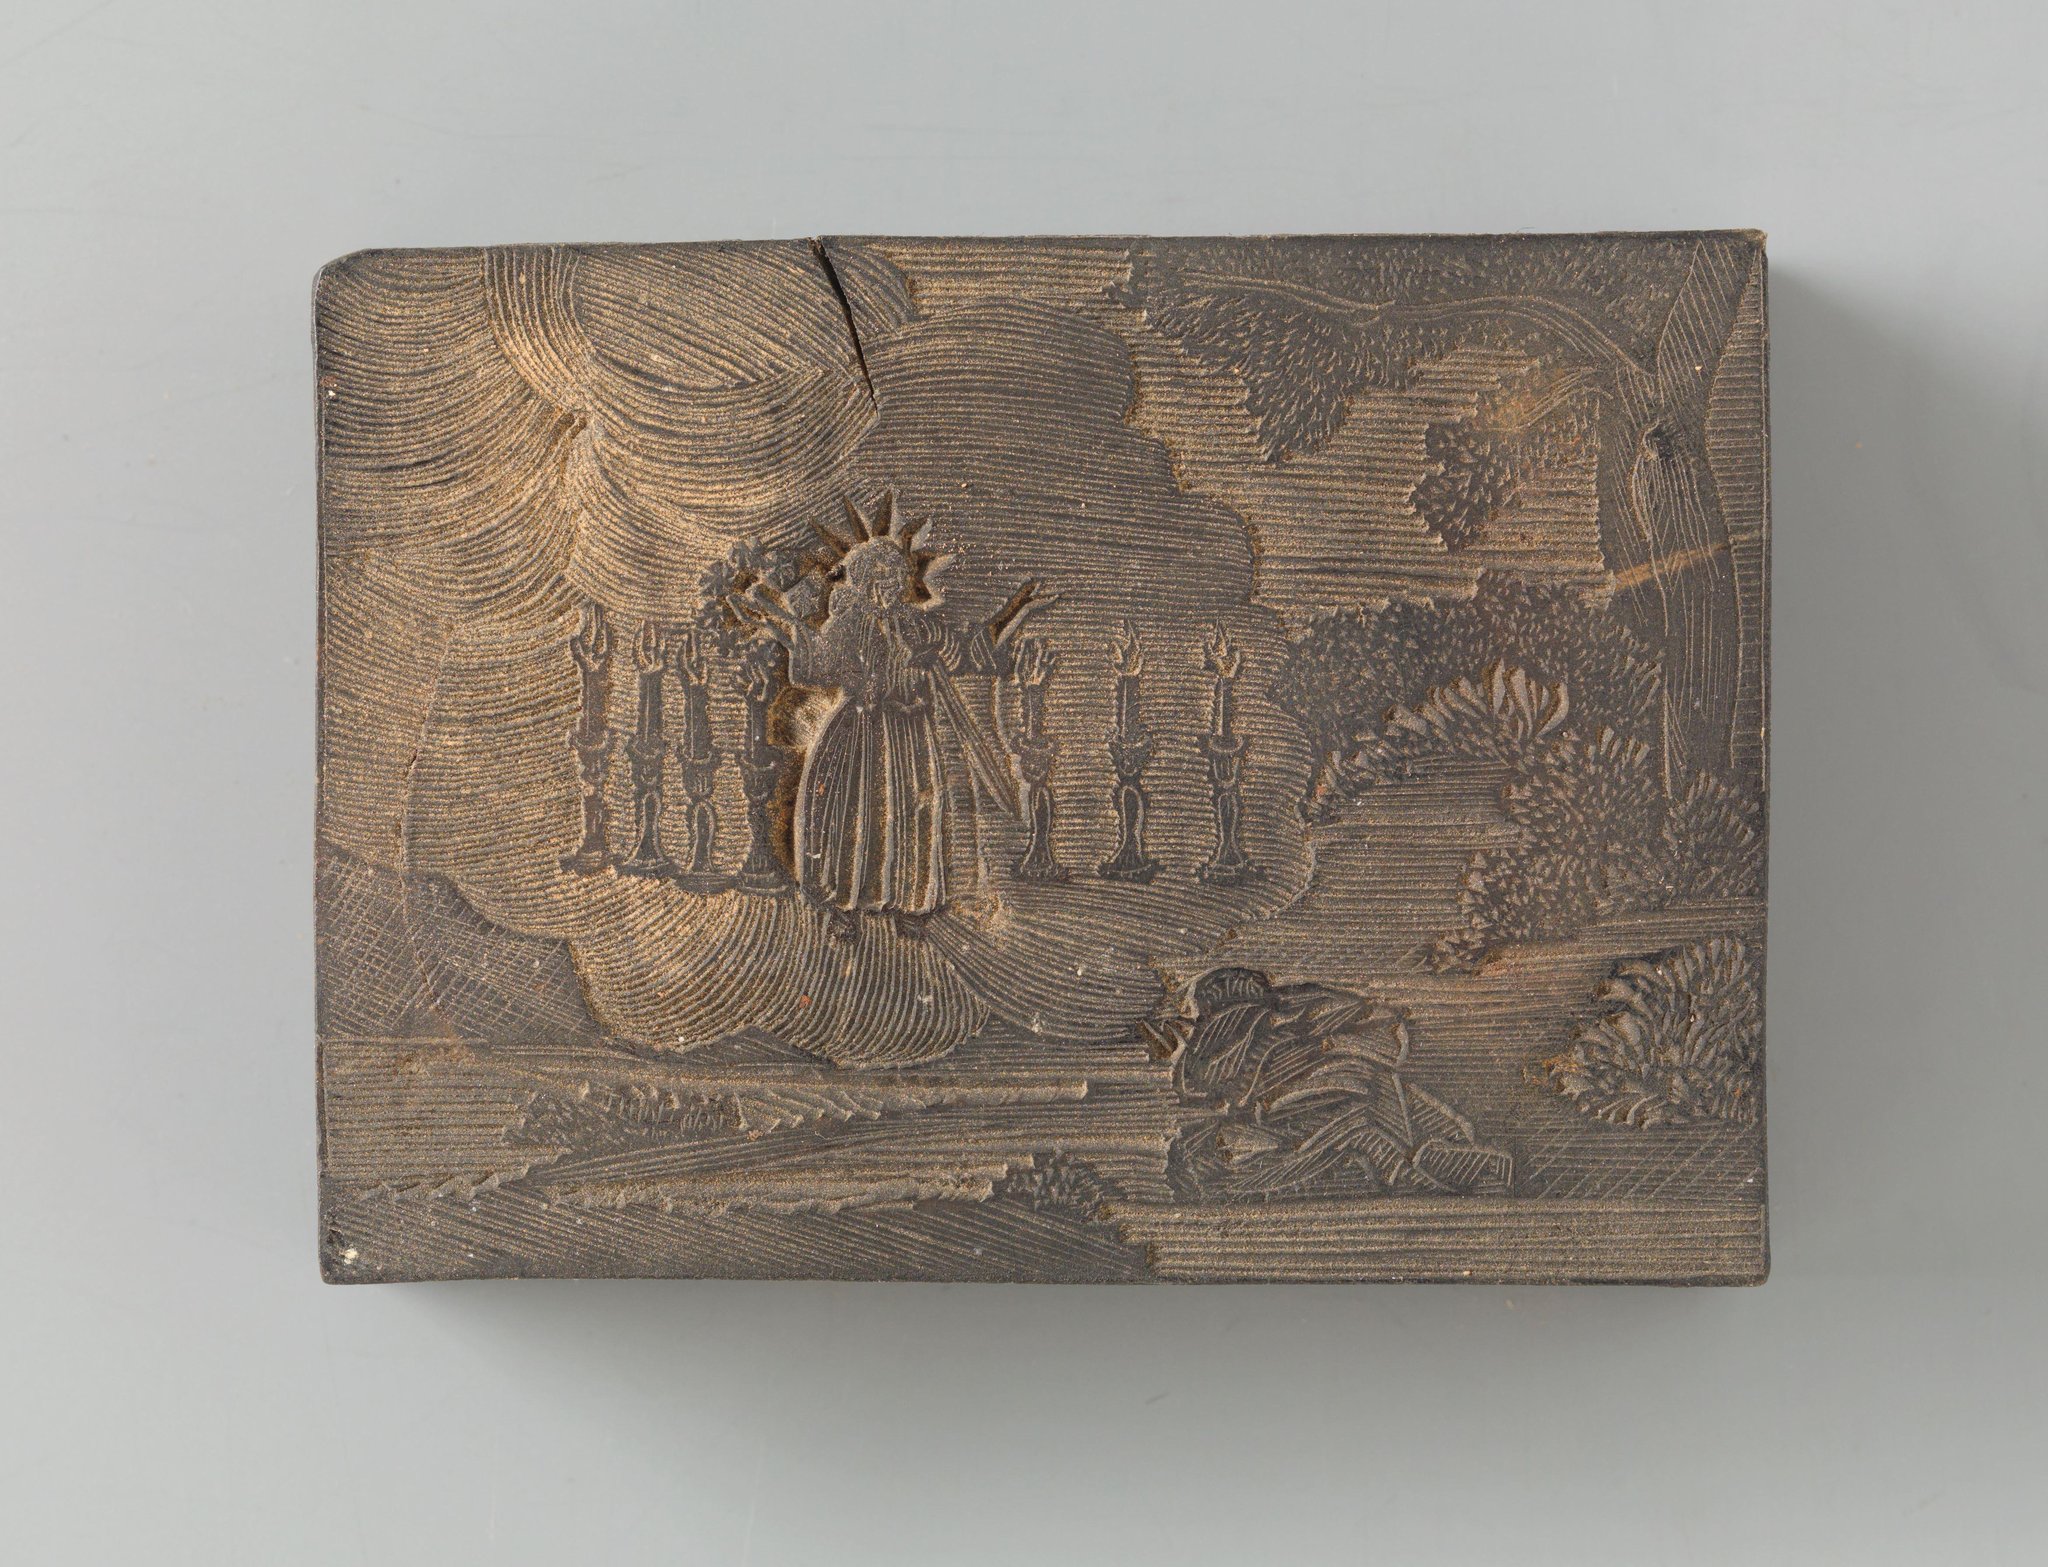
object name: wood block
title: Bijbel-illustraties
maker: Anonymous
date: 1550-1699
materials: wood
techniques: woodcut